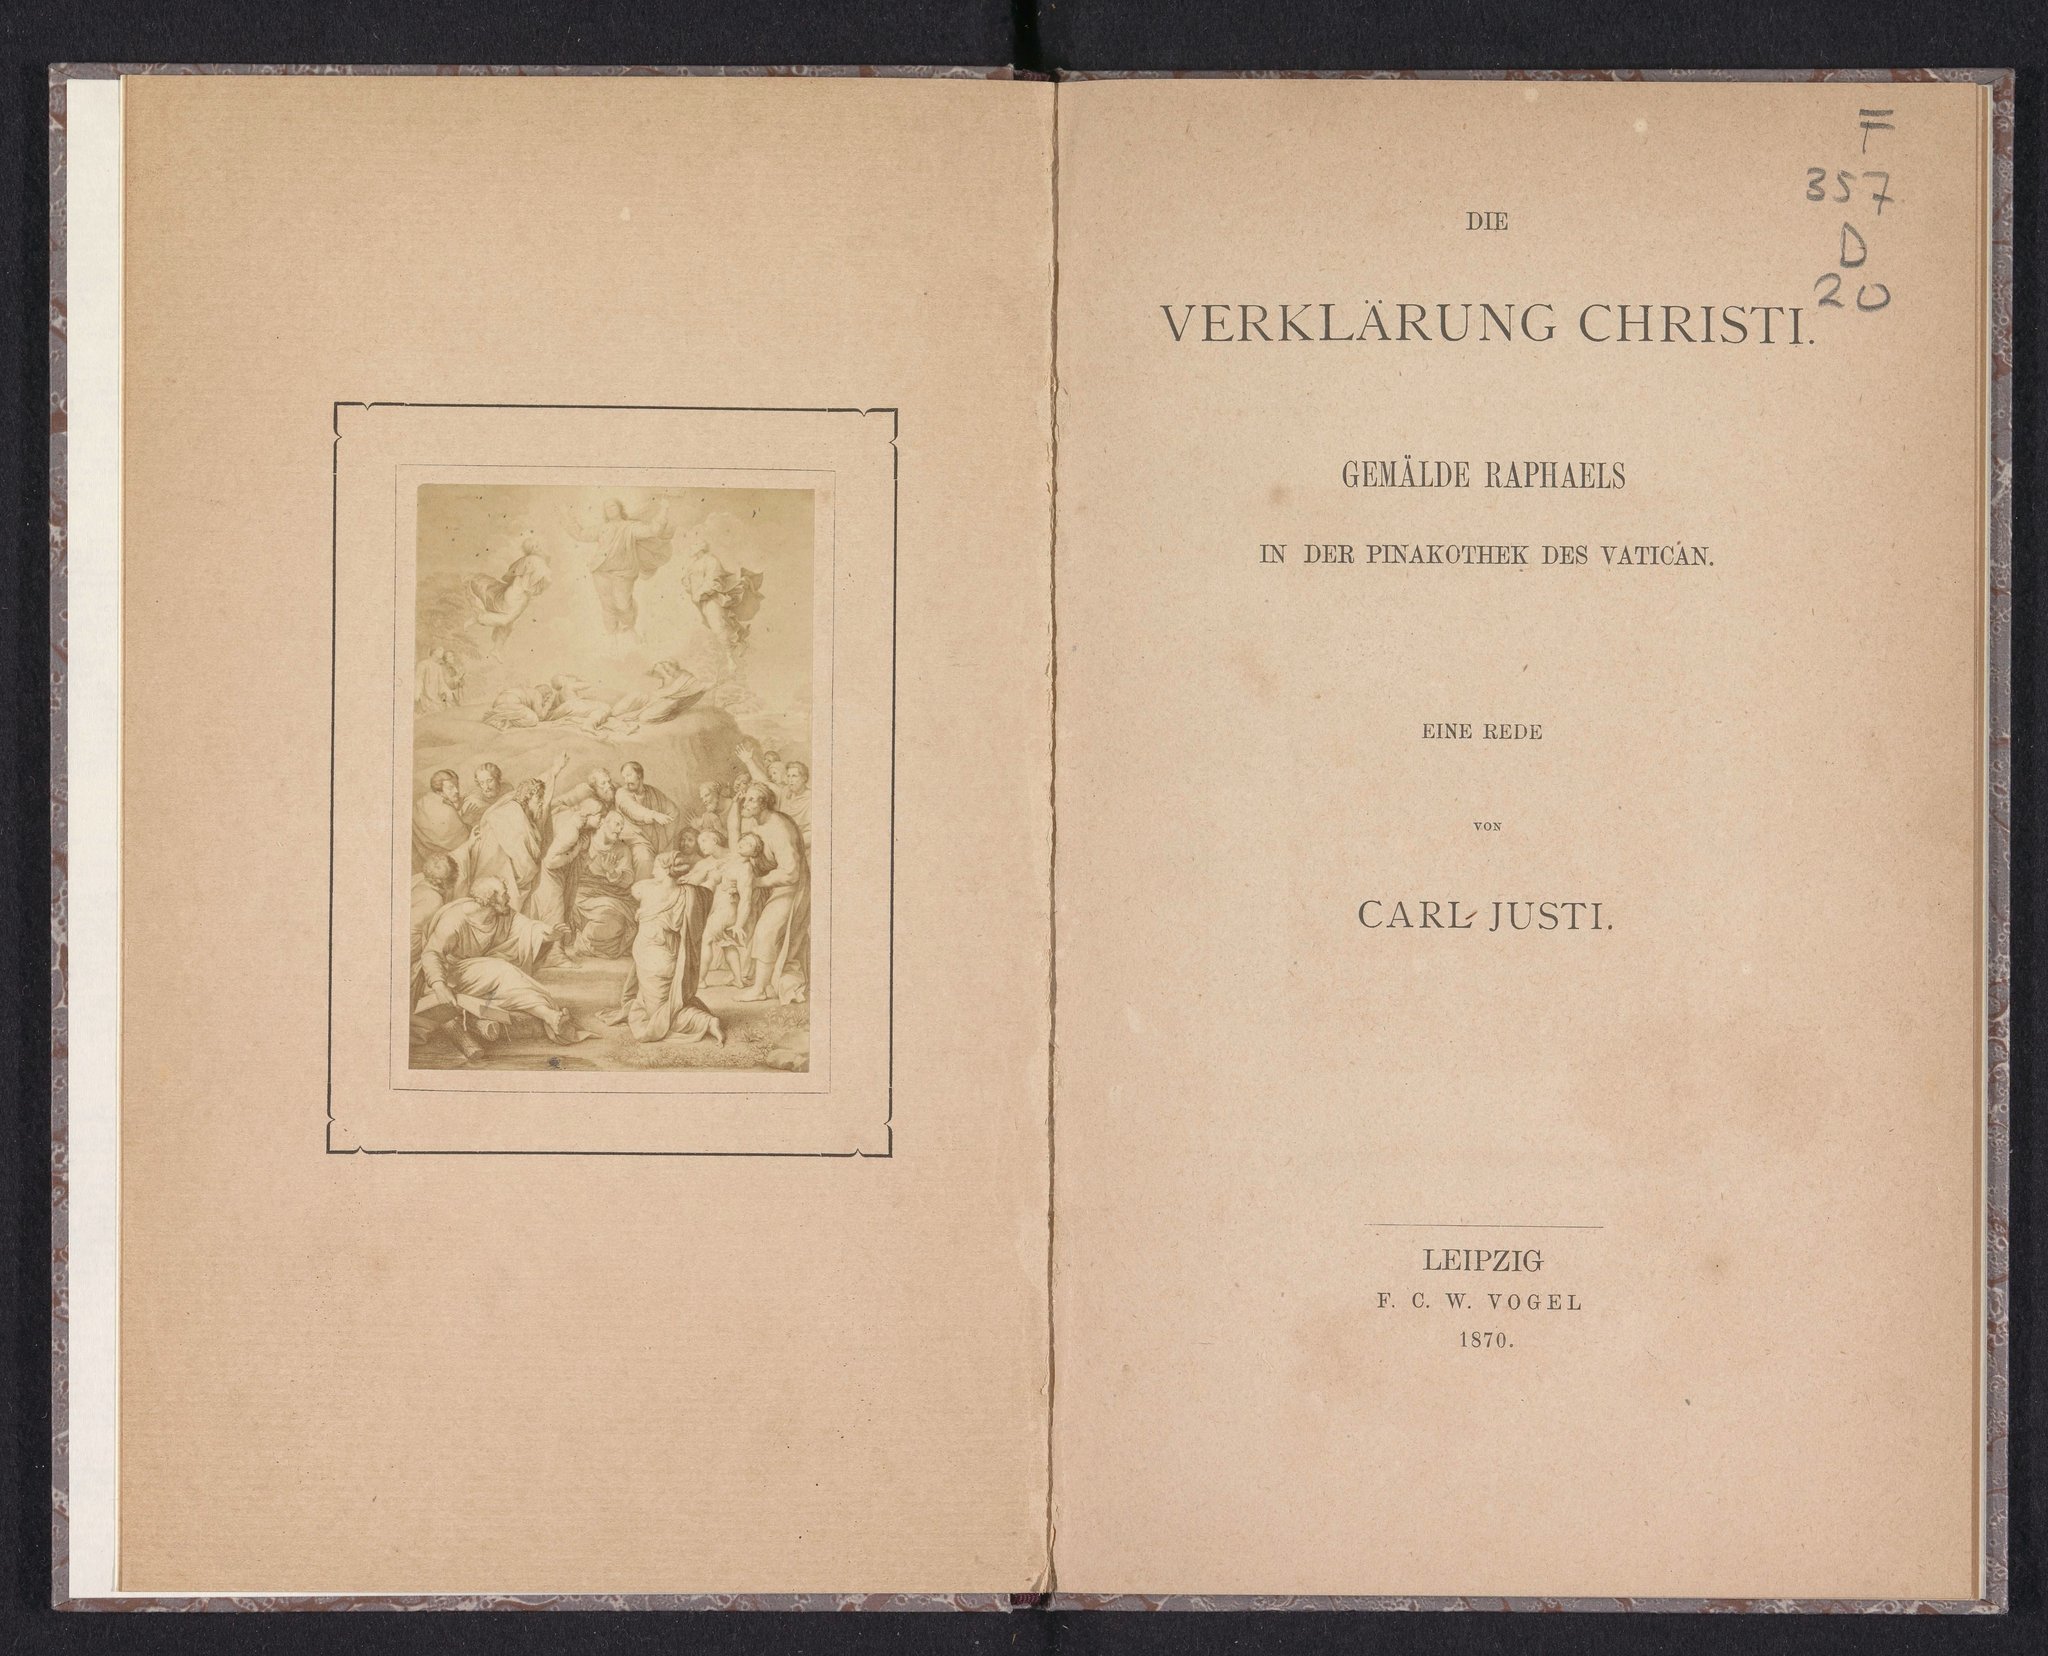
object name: book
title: Die Verklärung Christi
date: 1870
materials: cardboard, linen, paper, photographic support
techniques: albumen print, printing, marbling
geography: leipzig